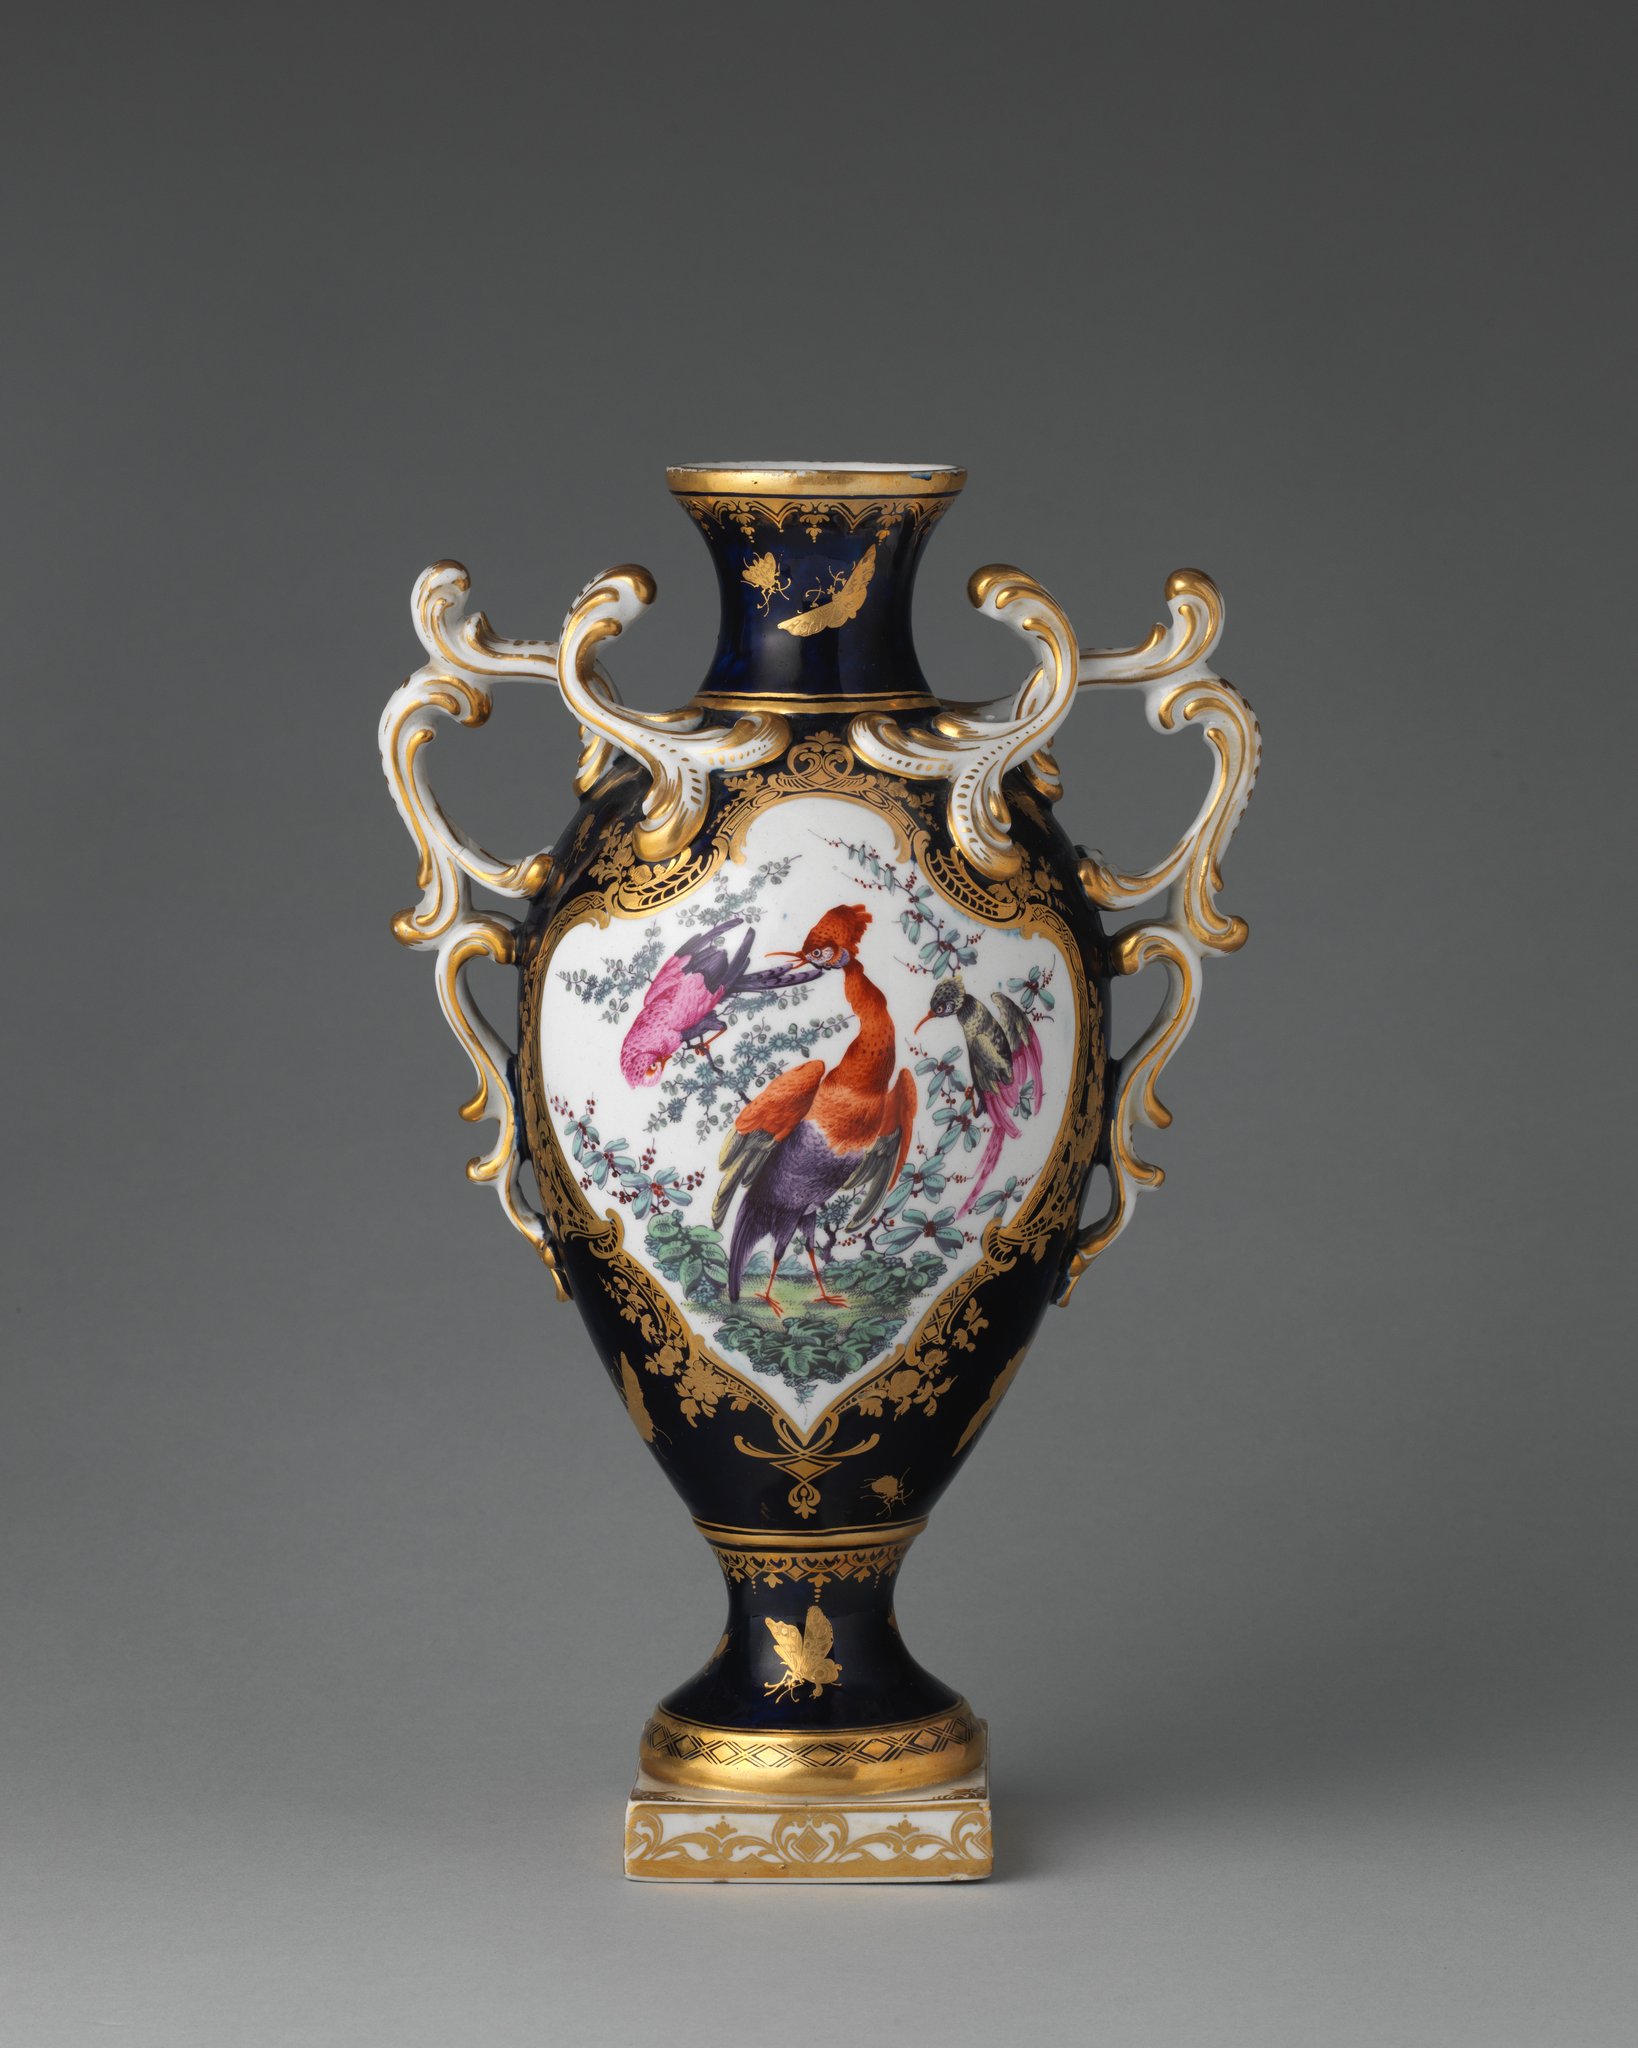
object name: vase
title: Vase (one of a pair)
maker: chelsea porcelain manufactory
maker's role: factory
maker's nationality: british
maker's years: 1744-1784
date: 1765-1770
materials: soft paste porcelain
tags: birds,butterflies,plants